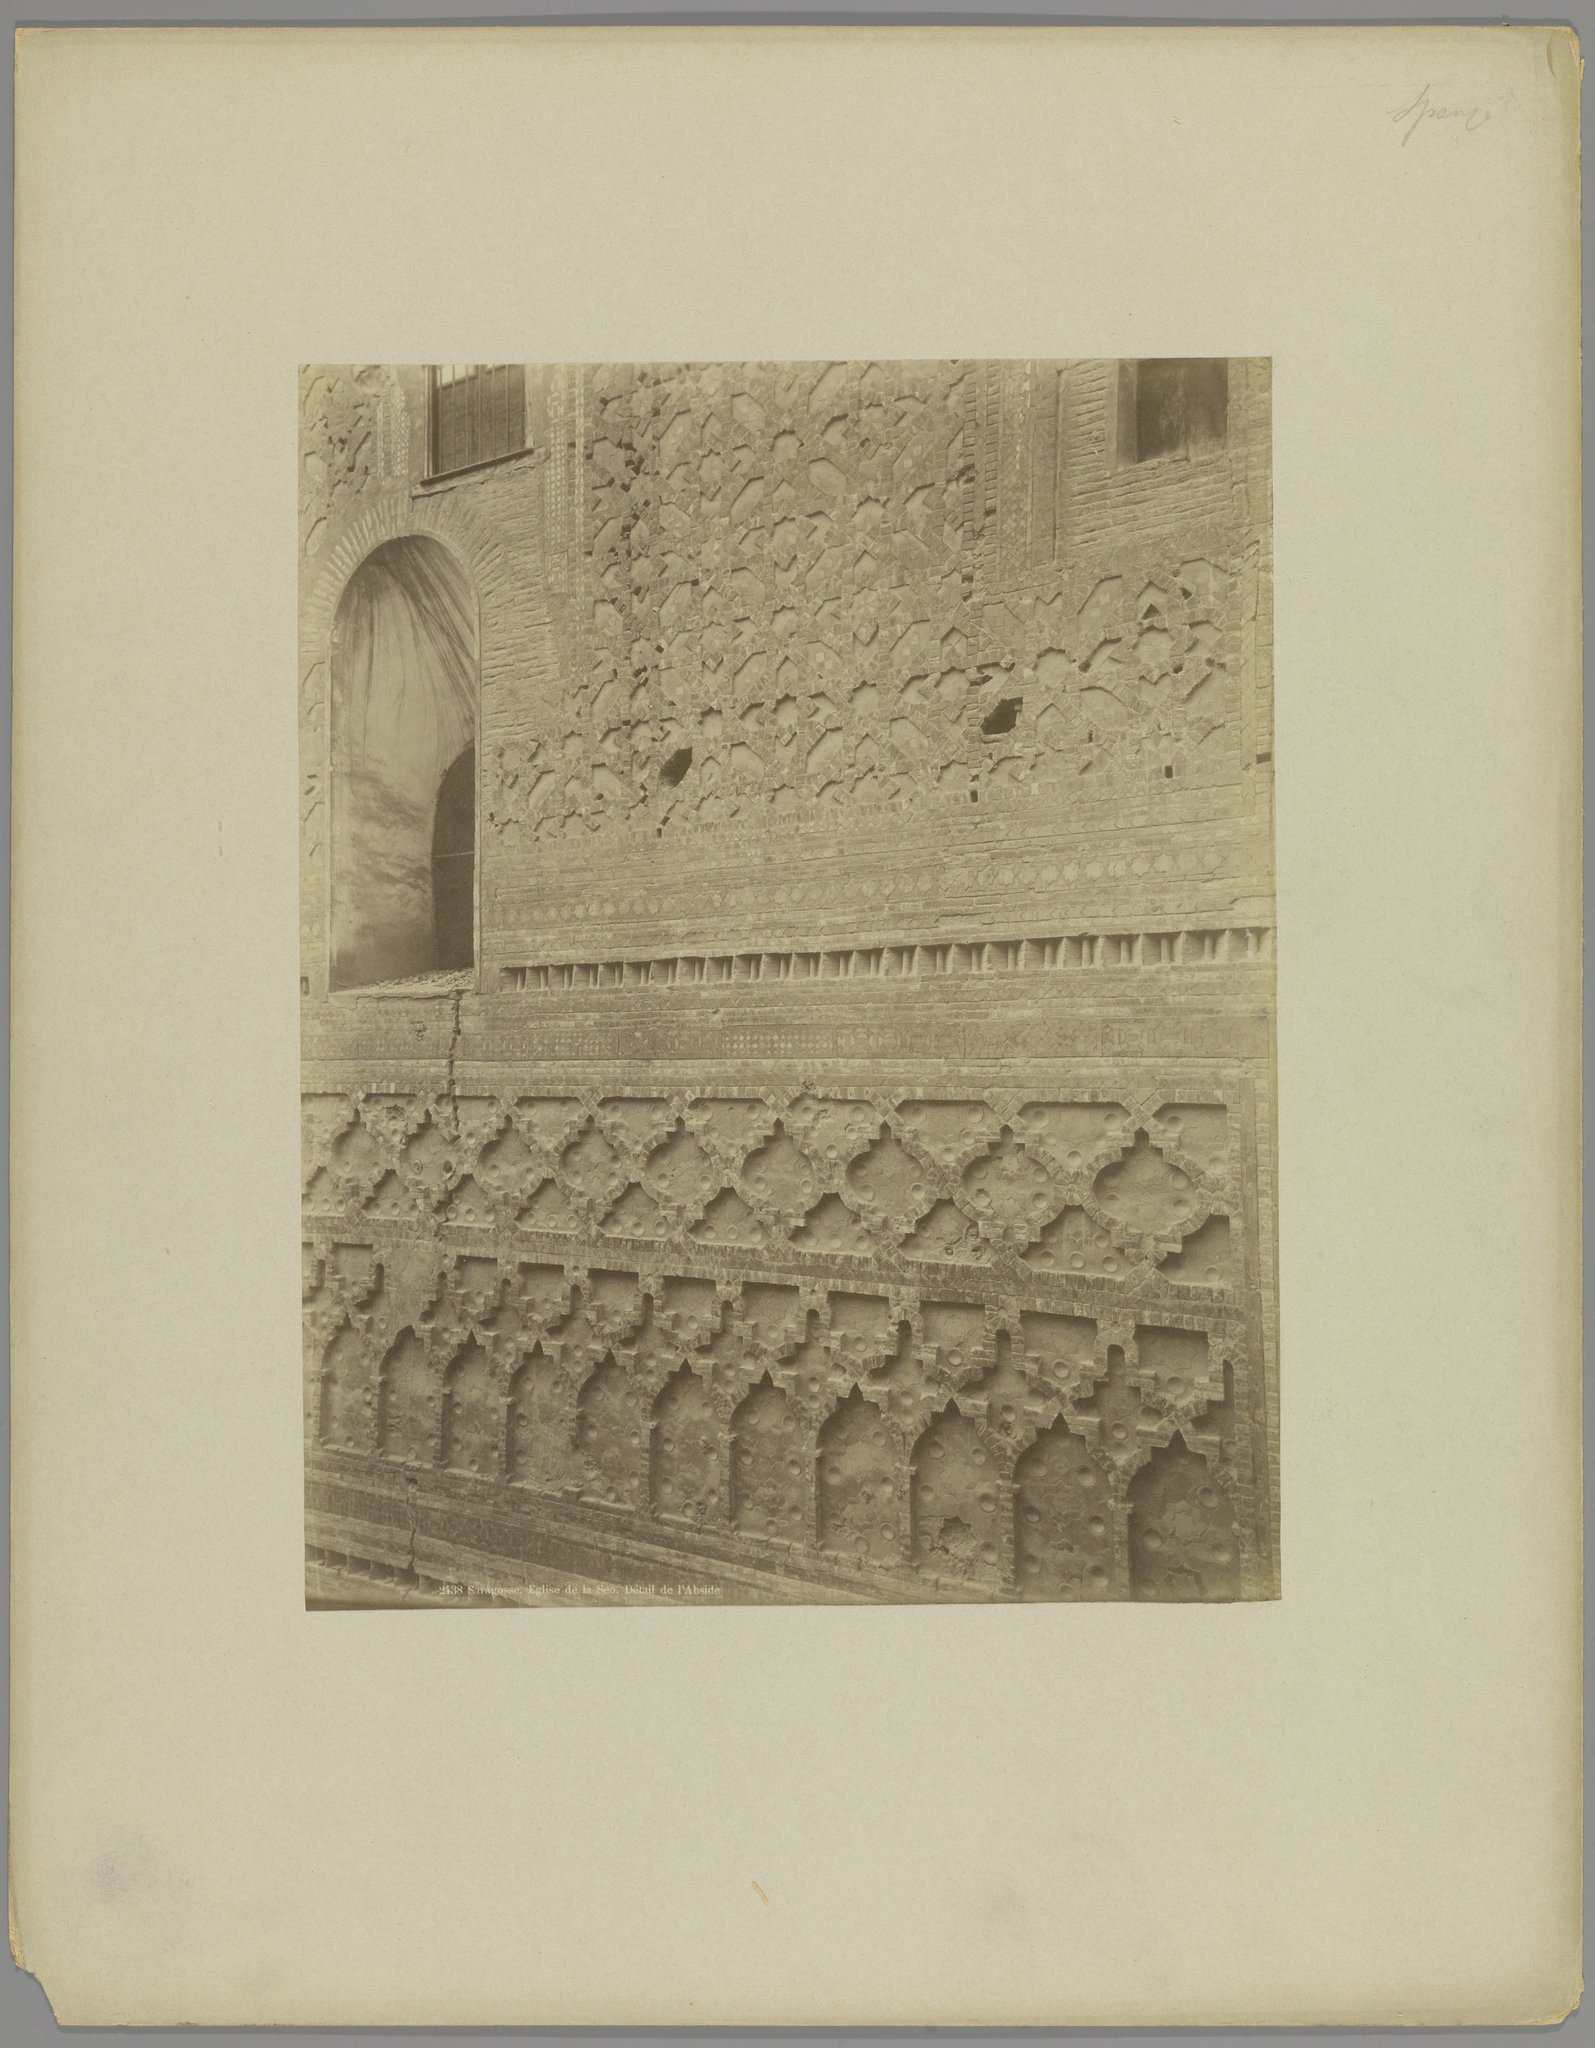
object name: photograph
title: Deel van het exterieur van La Seo te Zaragoza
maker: Anonymous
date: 1875-1900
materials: cardboard, photographic support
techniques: albumen print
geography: zaragoza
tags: church (exterior), parts of church exterior and annexes: façade, ornament ~ geometric motifs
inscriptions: inscription: ‘Spanje’, inscription: ‘X k1 fl 1’, inscription: ‘T & M B.F.K. Rive[...]’, number: ‘2438’, collector's mark: Lugt 3937